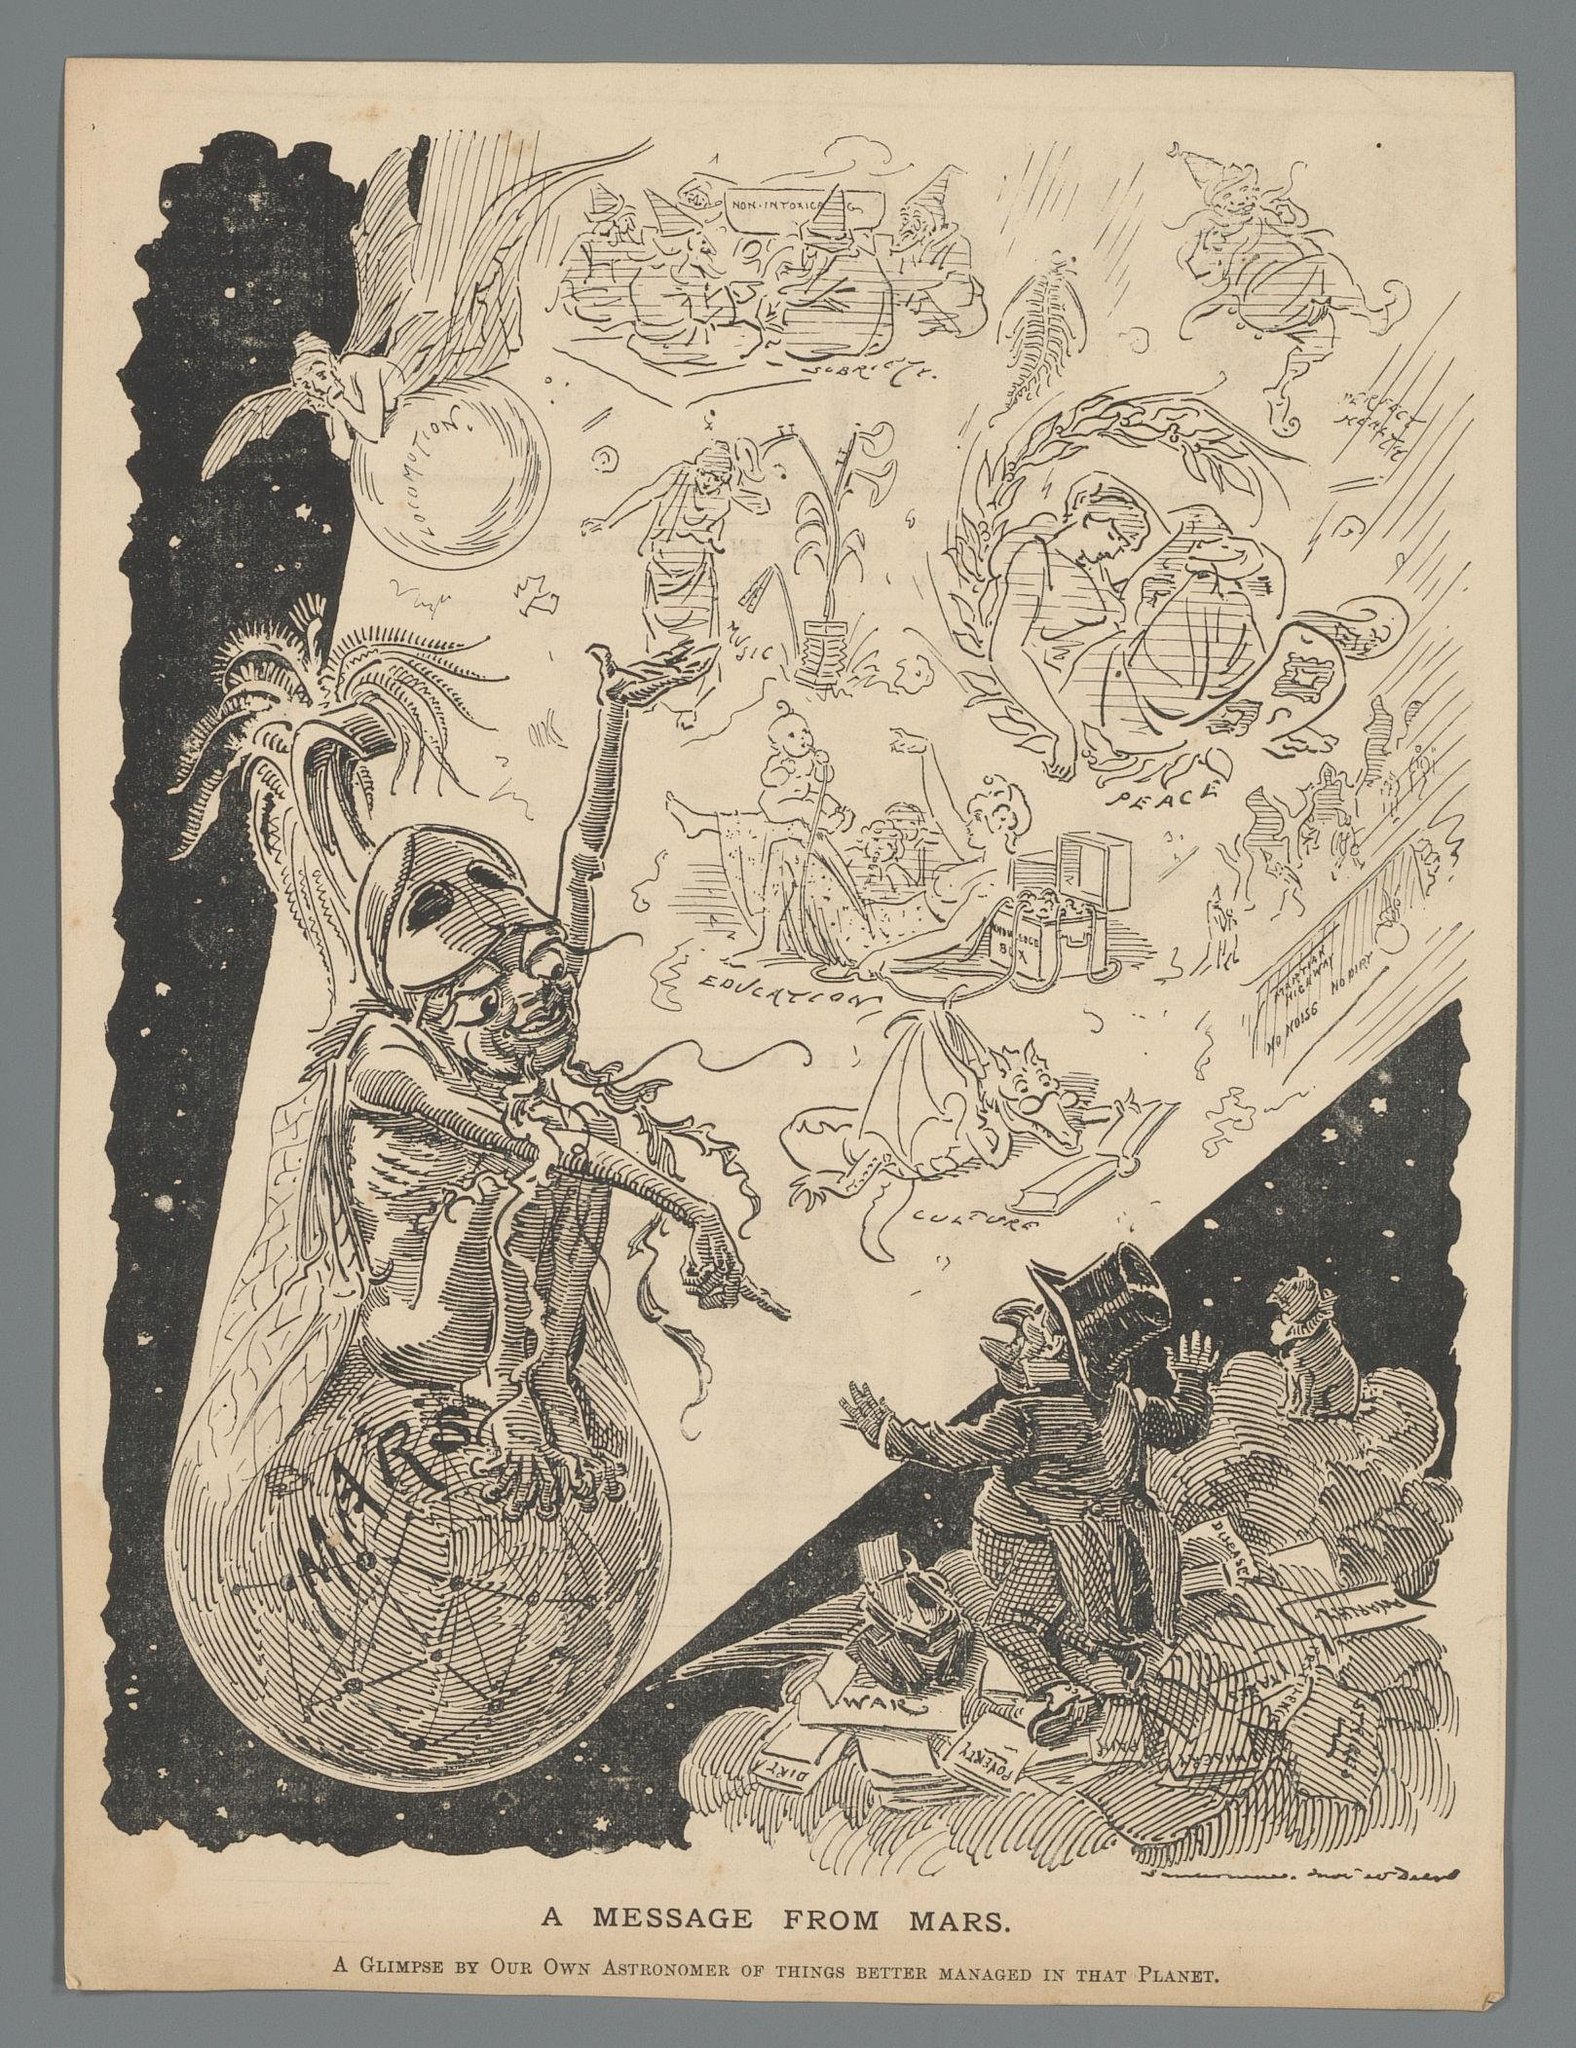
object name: cartoon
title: A message from Mars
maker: edward linley sambourne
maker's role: draughtsman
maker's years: 1844-1910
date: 1896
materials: paper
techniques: line block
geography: england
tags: beings from outer space, mars (planet), political caricatures and satires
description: Mr. Punch ziet dat de zaken op de planeet Mars beter zijn geregeld dan op aarde. Spotprent in het Engelse satirische tijdschrift Punch, 1896.